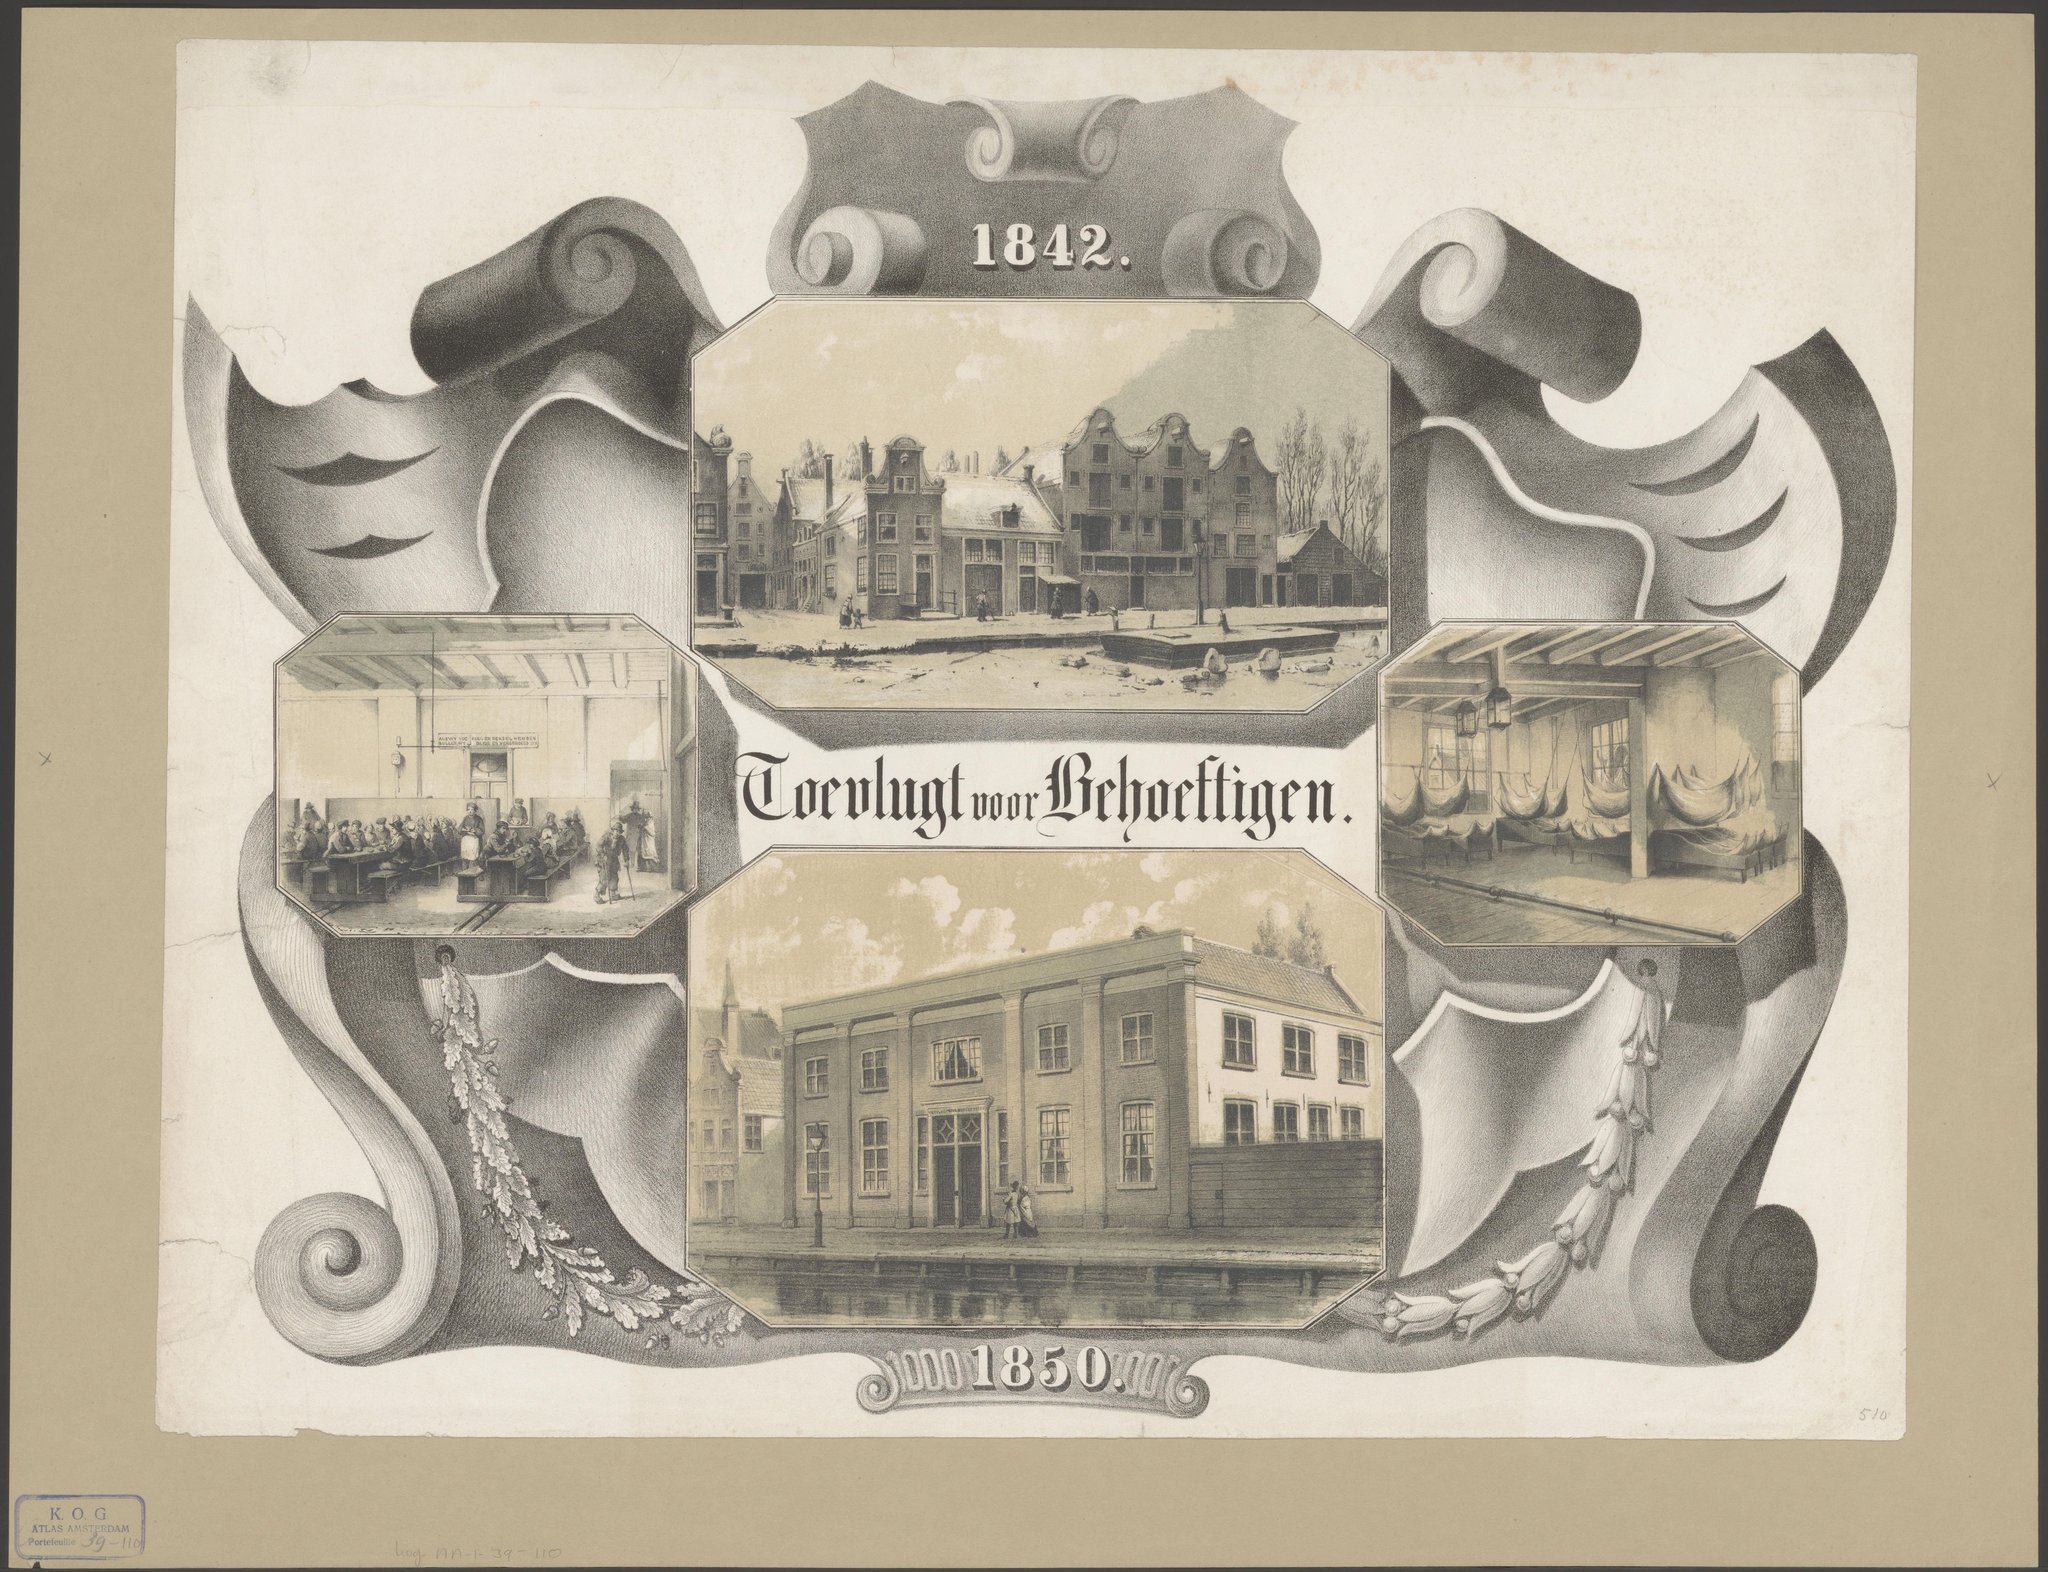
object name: print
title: Toevlugt voor Behoeftigen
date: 1850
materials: paper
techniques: lithograph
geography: netherlands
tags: public welfare, communal rooms, bed, canals, waters (in city) (+ city(-scape) with figures, staffage)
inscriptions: collector's mark: Lugt 1641b, stamp: ‘T.v.B.’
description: Onderwerpsrubriek binnen de Atlas Amsterdam: Armwezen en liefdadige instellingen: III. Verschillende gestichten en instellingen / Hofjes: Toevlucht voor Behoeftigen.